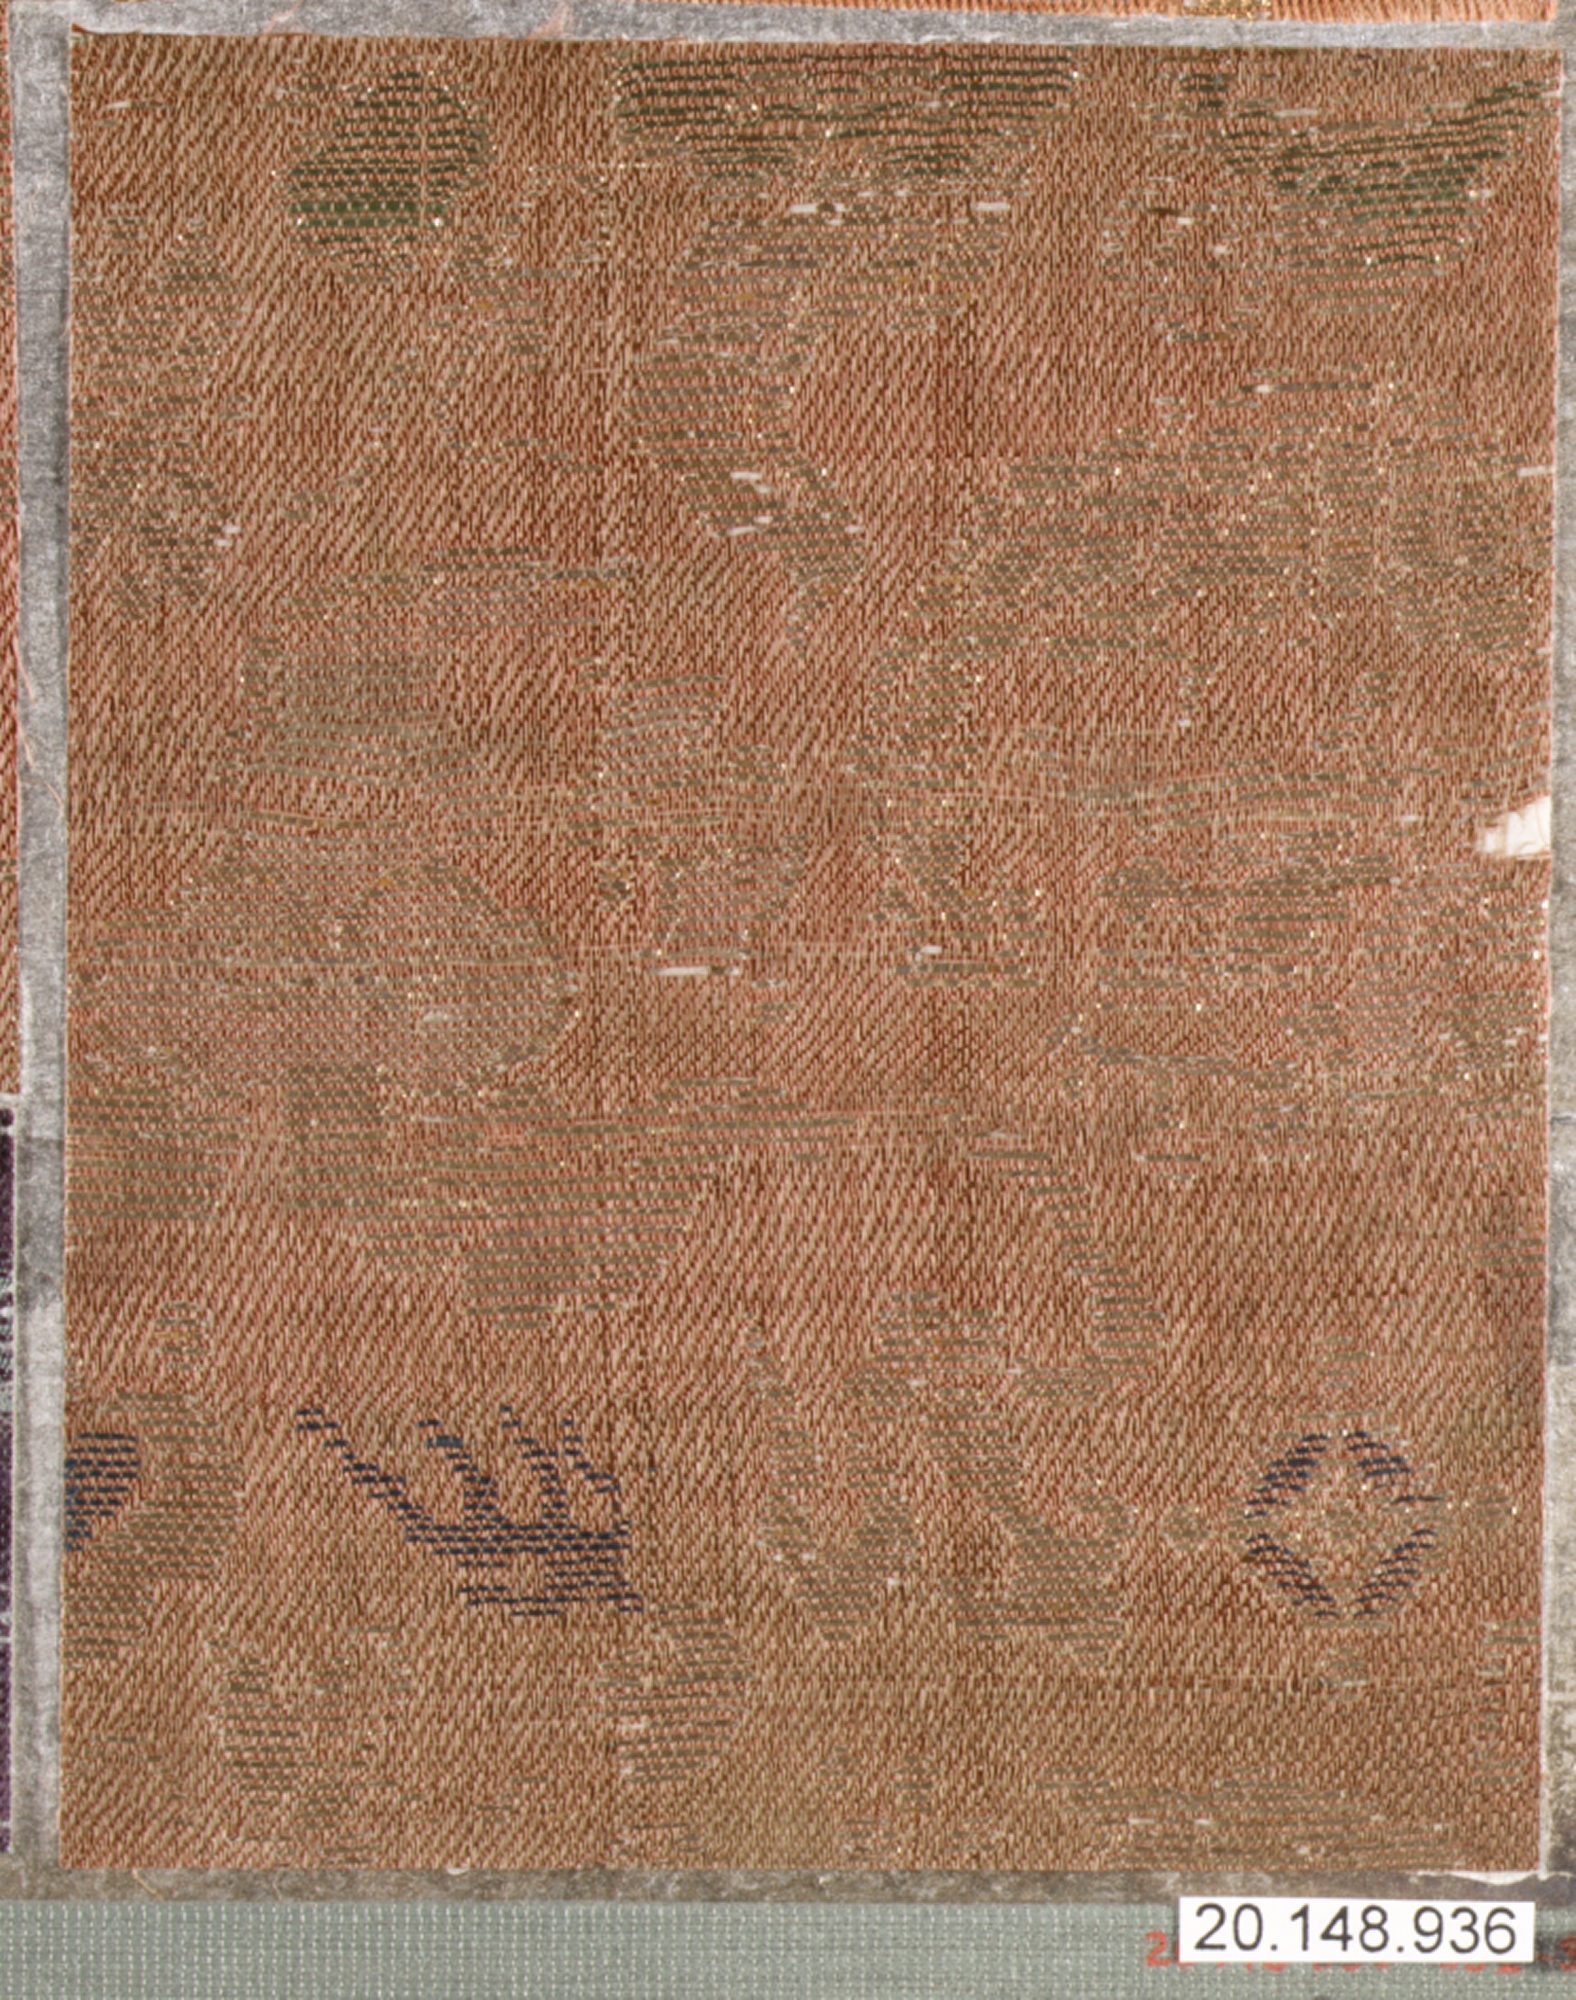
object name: piece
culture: japanese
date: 1701-1800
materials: silk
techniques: compound weave